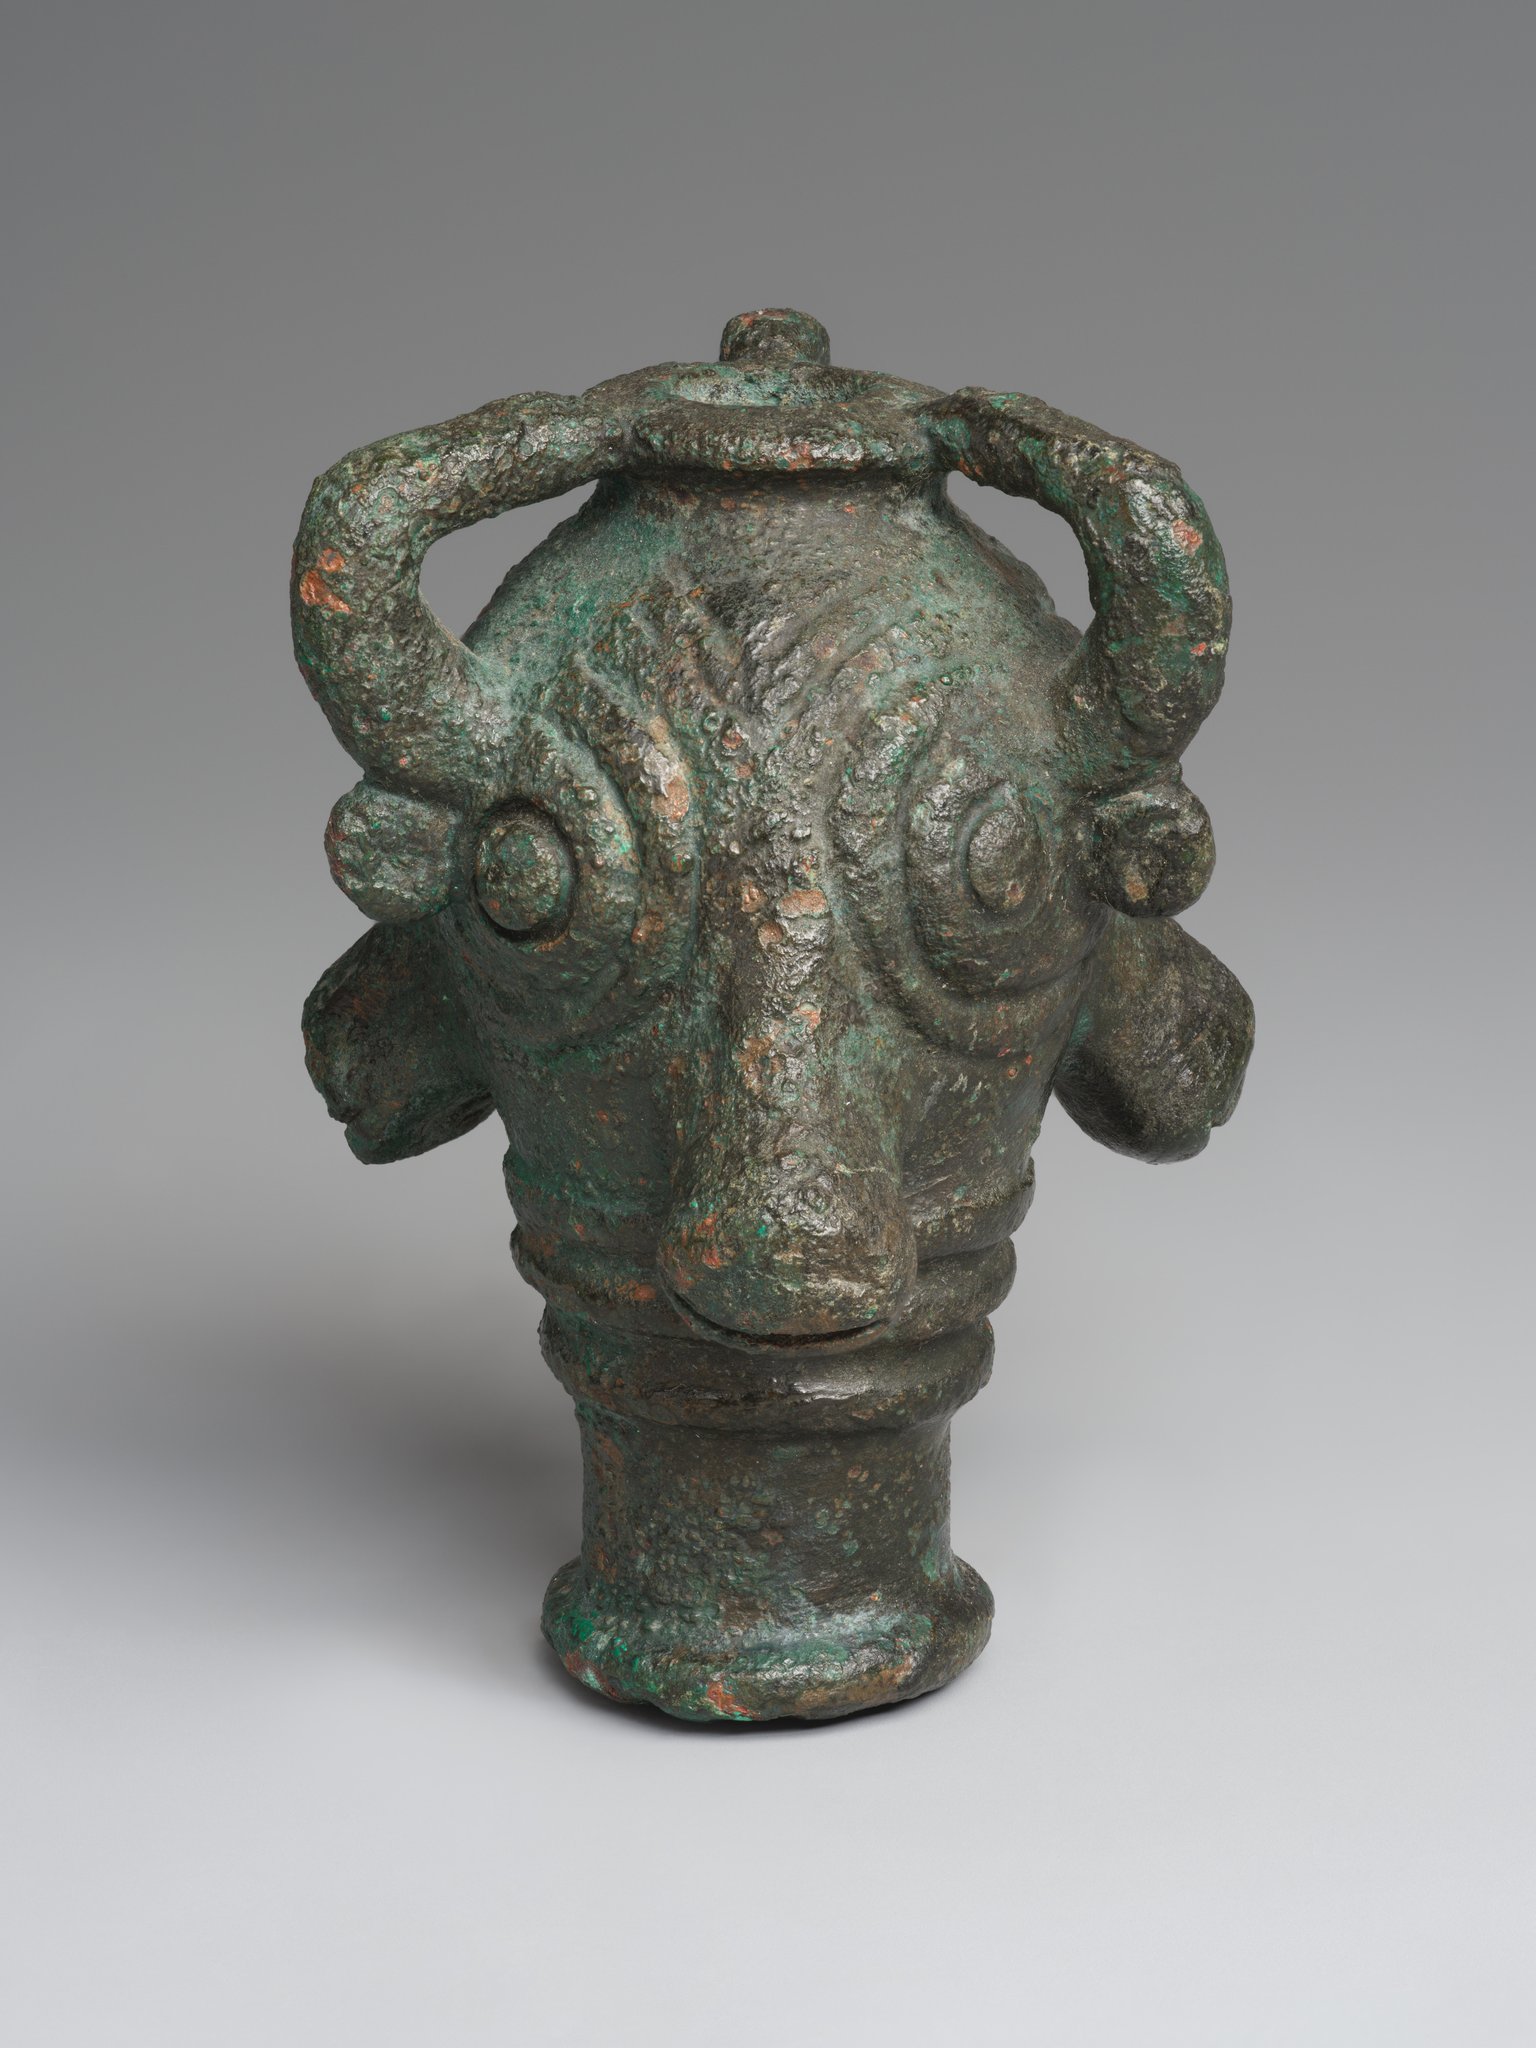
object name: mace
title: Mace head in the form of triple bulls' heads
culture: iranian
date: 1000-668 BCE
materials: bronze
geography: western iran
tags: bulls